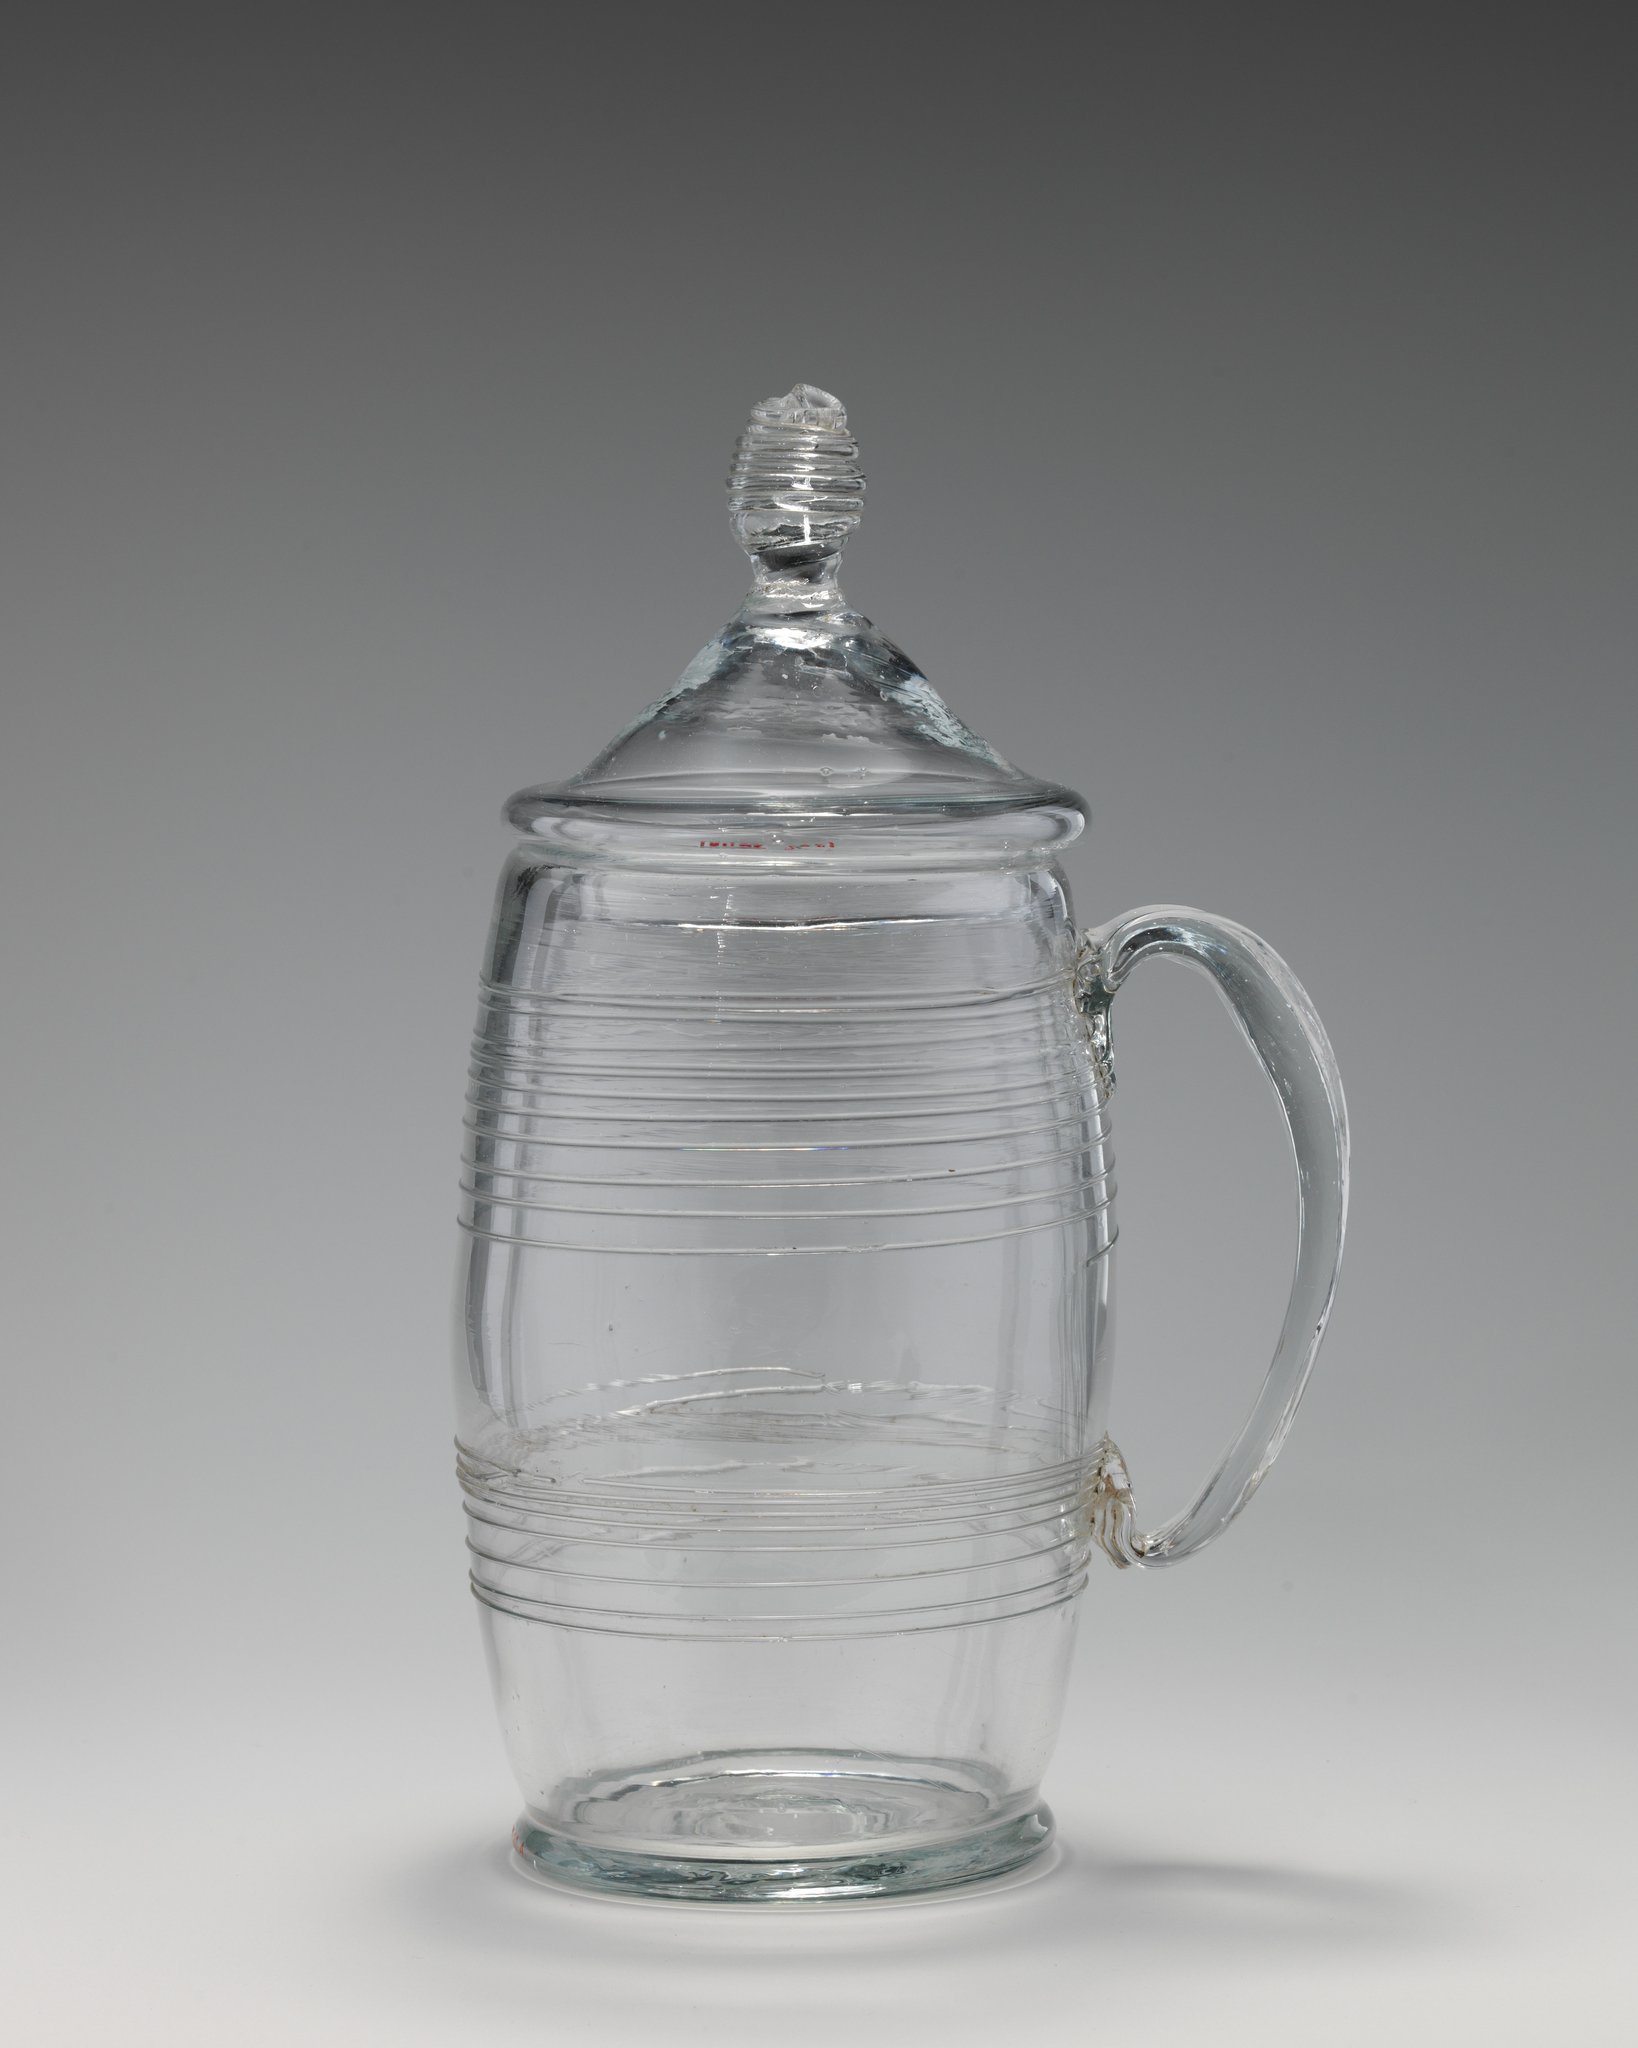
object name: tankard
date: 1767-1800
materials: glass